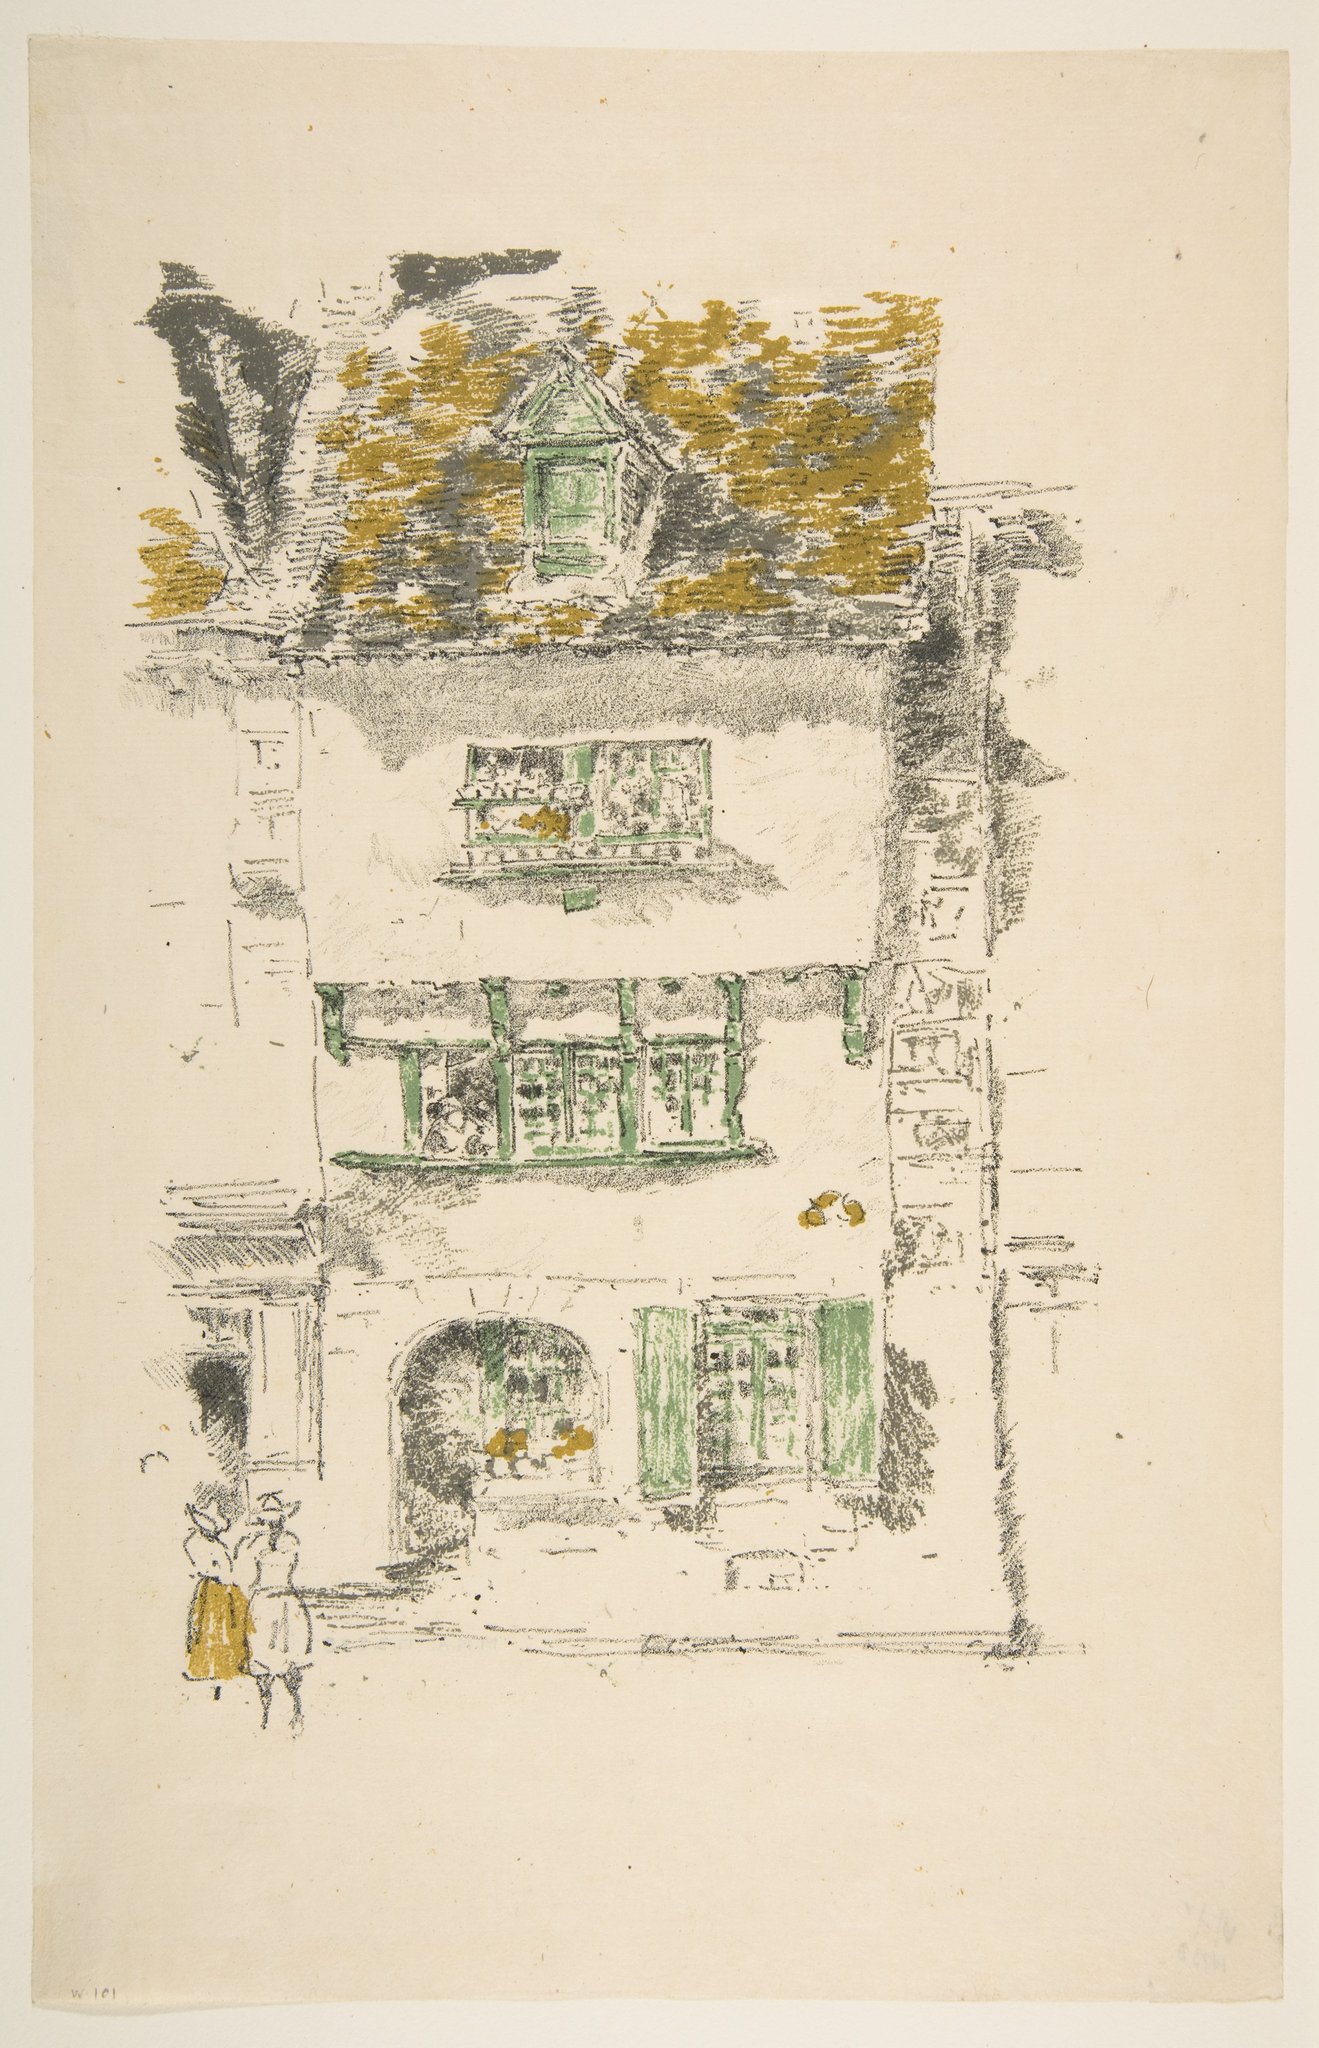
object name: print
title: Yellow House, Lannion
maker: james mcneill whistler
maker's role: artist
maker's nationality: american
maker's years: 1834-1903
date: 1893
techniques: printing, scraping, lithography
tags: human figures,houses